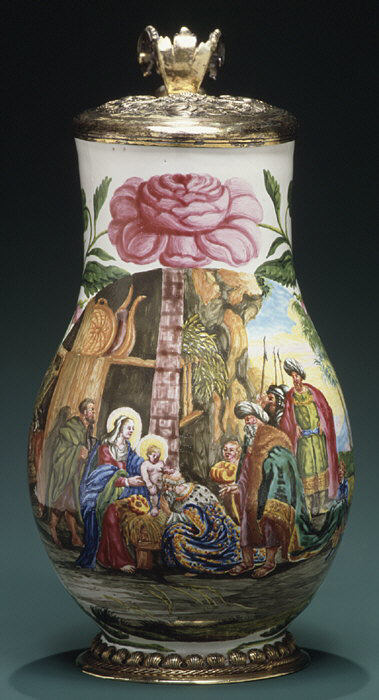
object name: jug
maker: wolf rössler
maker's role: decorator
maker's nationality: german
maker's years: 1650-1717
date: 1690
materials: earthenware, silver gilt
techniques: glazing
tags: men,flowers,madonna and child,adoration of the magi